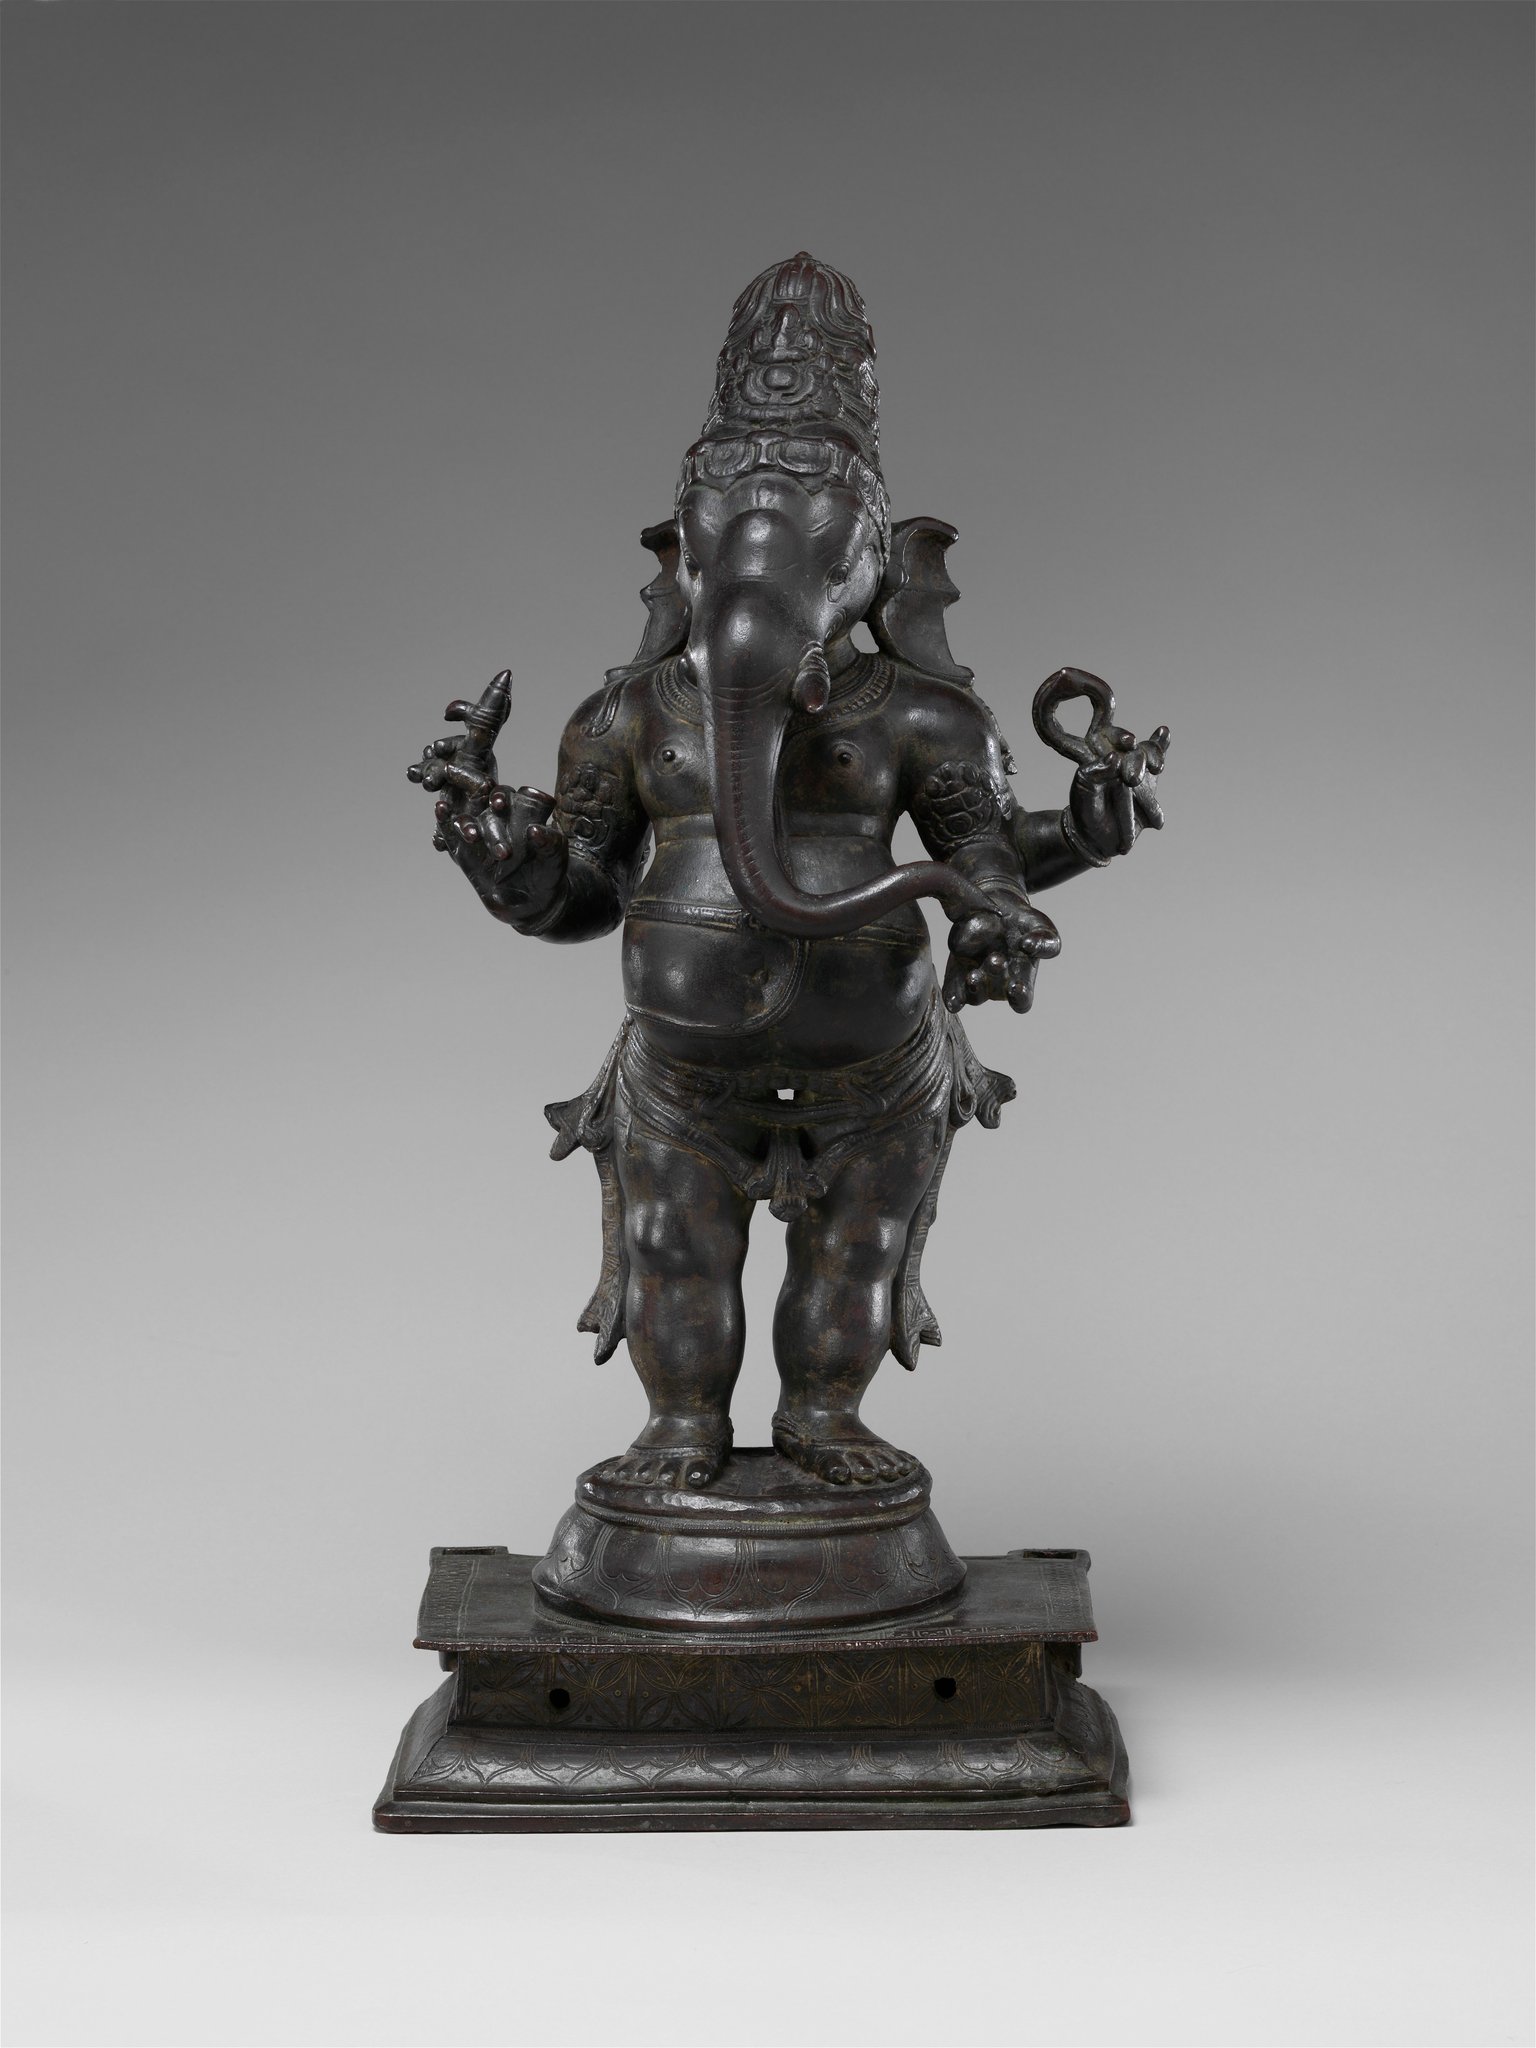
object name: figure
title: Ganesha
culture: tamil nadu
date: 1101-1200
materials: copper alloy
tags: ganesha